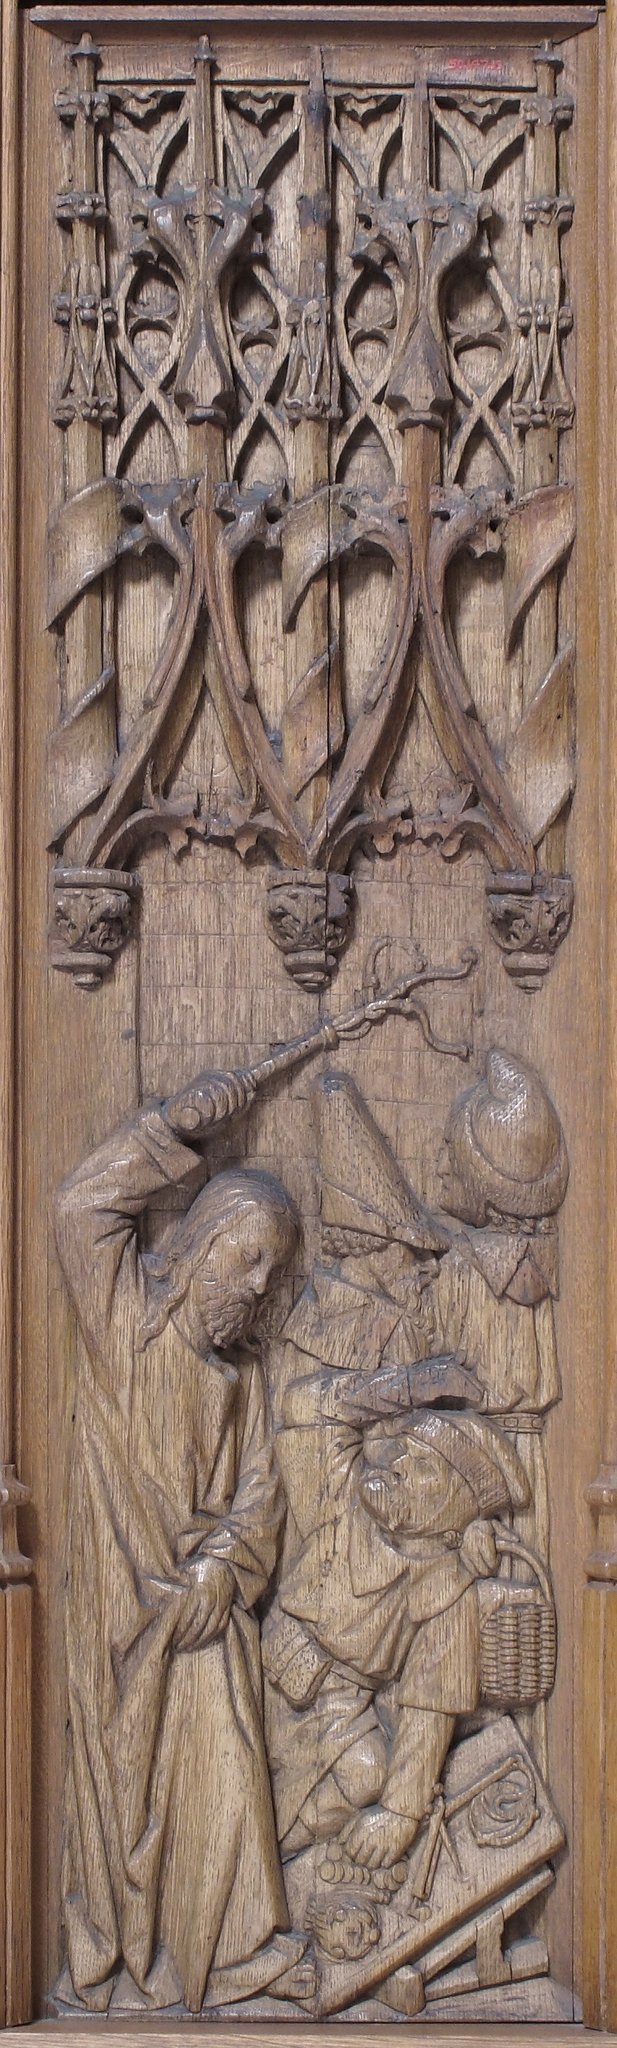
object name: panel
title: Panel with Christ Driving the Money-Changers from the Temple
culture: french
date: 1501-1533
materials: wood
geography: france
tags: men,christ